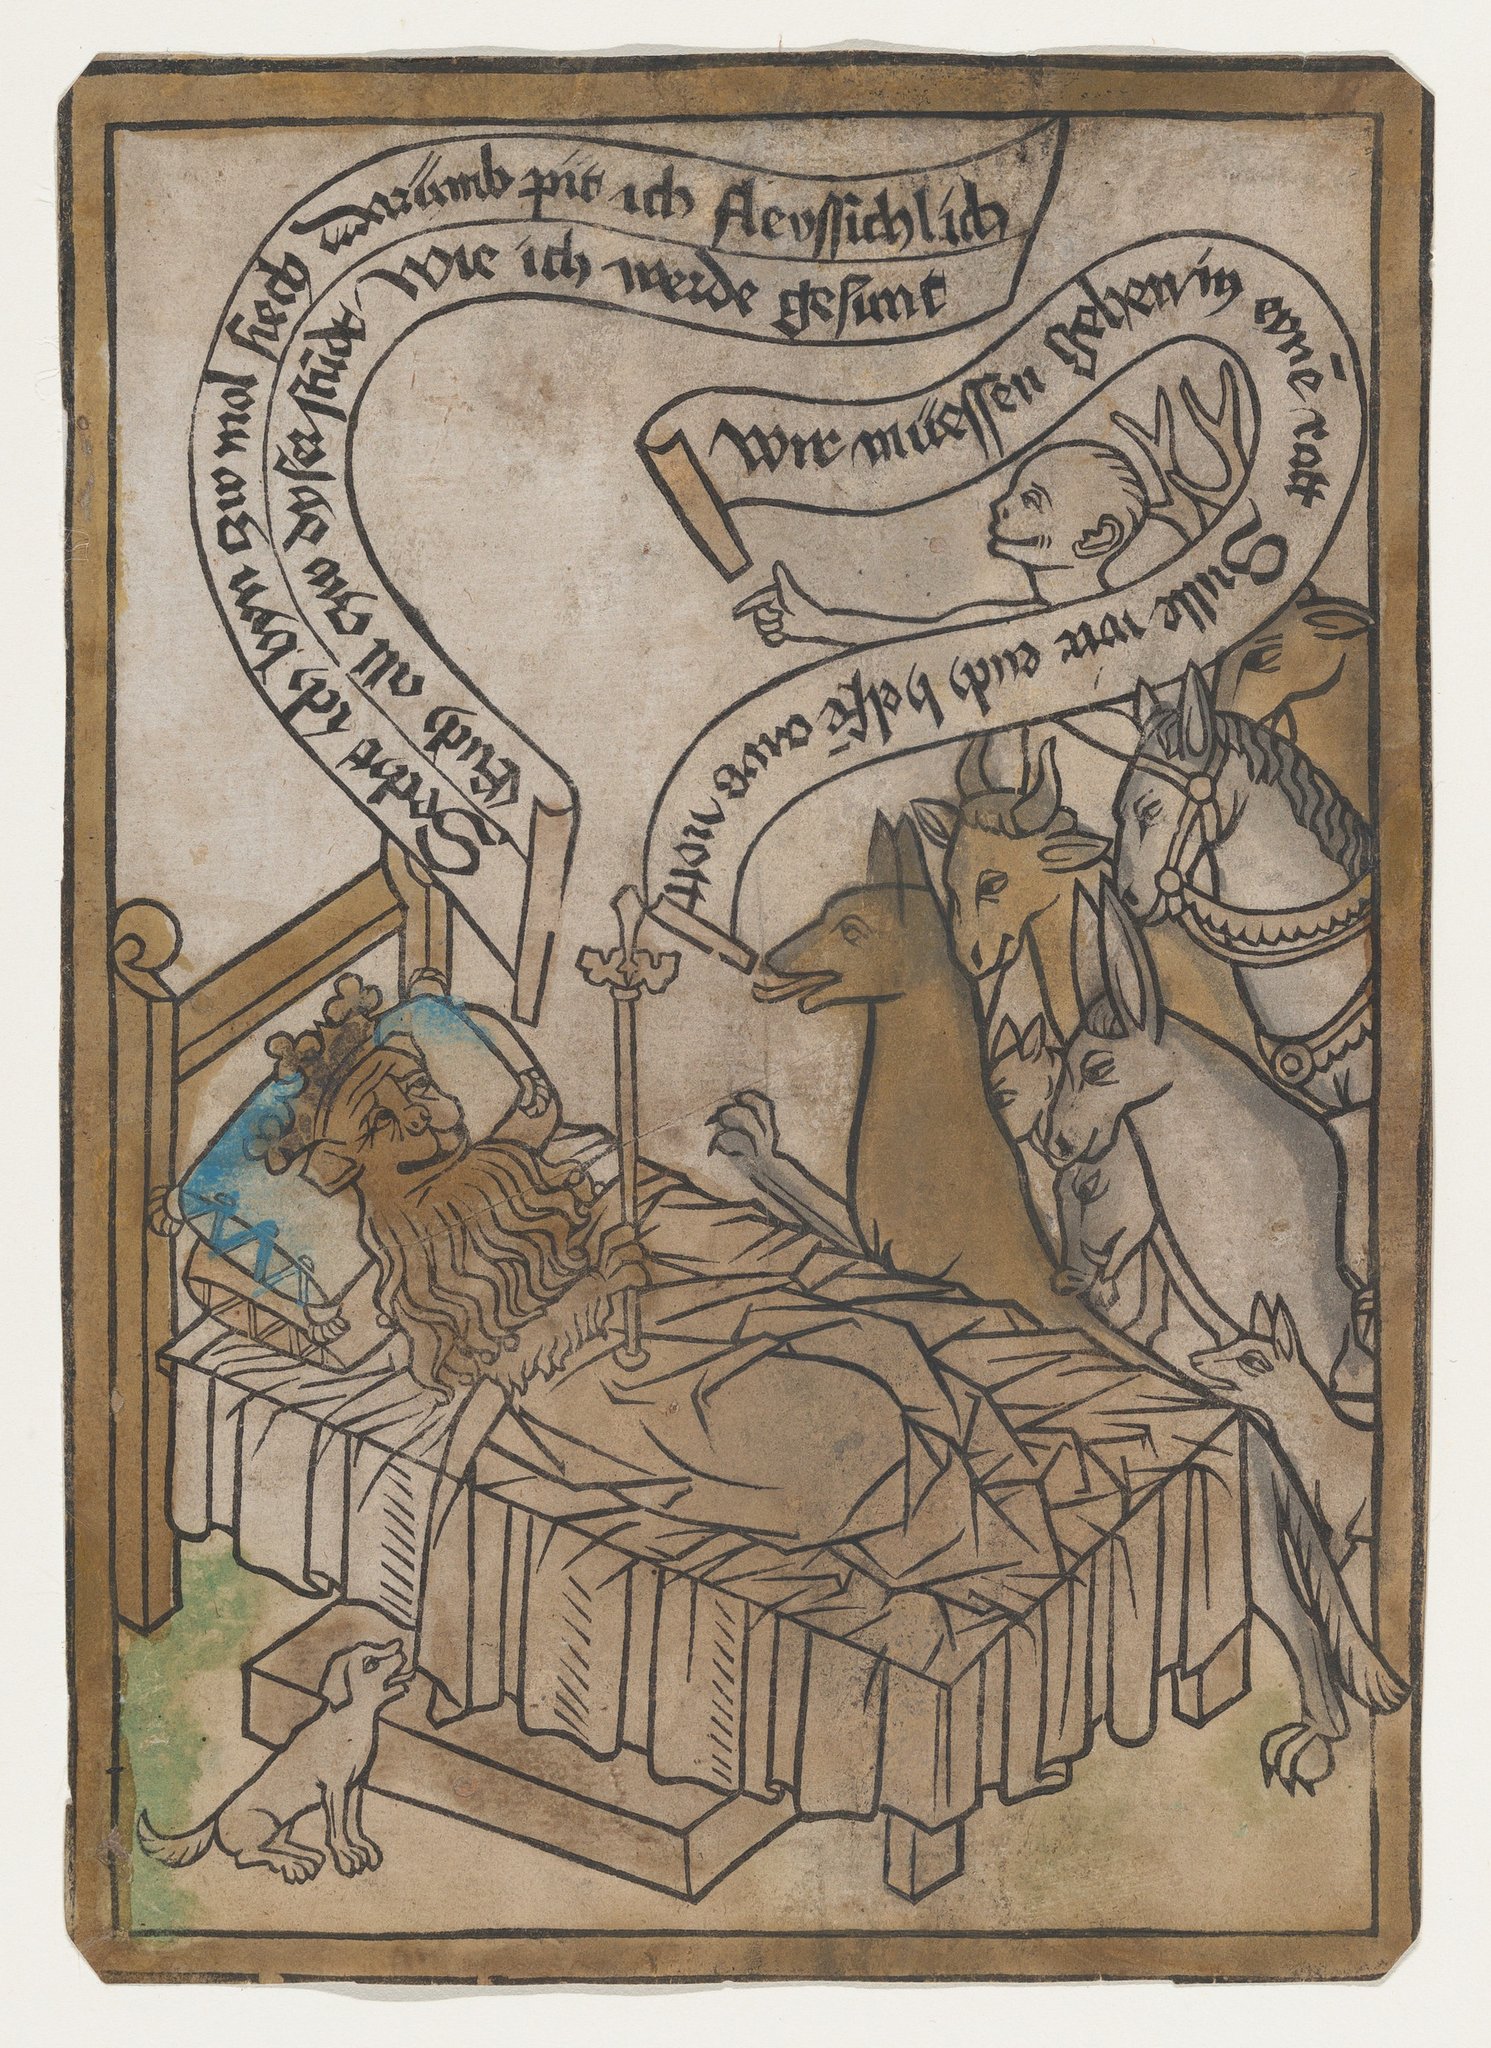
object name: print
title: The Sick Lion Summons the Animals to His Bedside from the Sick Lion blockbook, 2nd edition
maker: anonymous, german, ulm or basel, 15th century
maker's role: artist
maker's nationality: german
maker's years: 1400-1500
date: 1465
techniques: hand coloring, woodcut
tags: dogs,donkeys,horses,lions